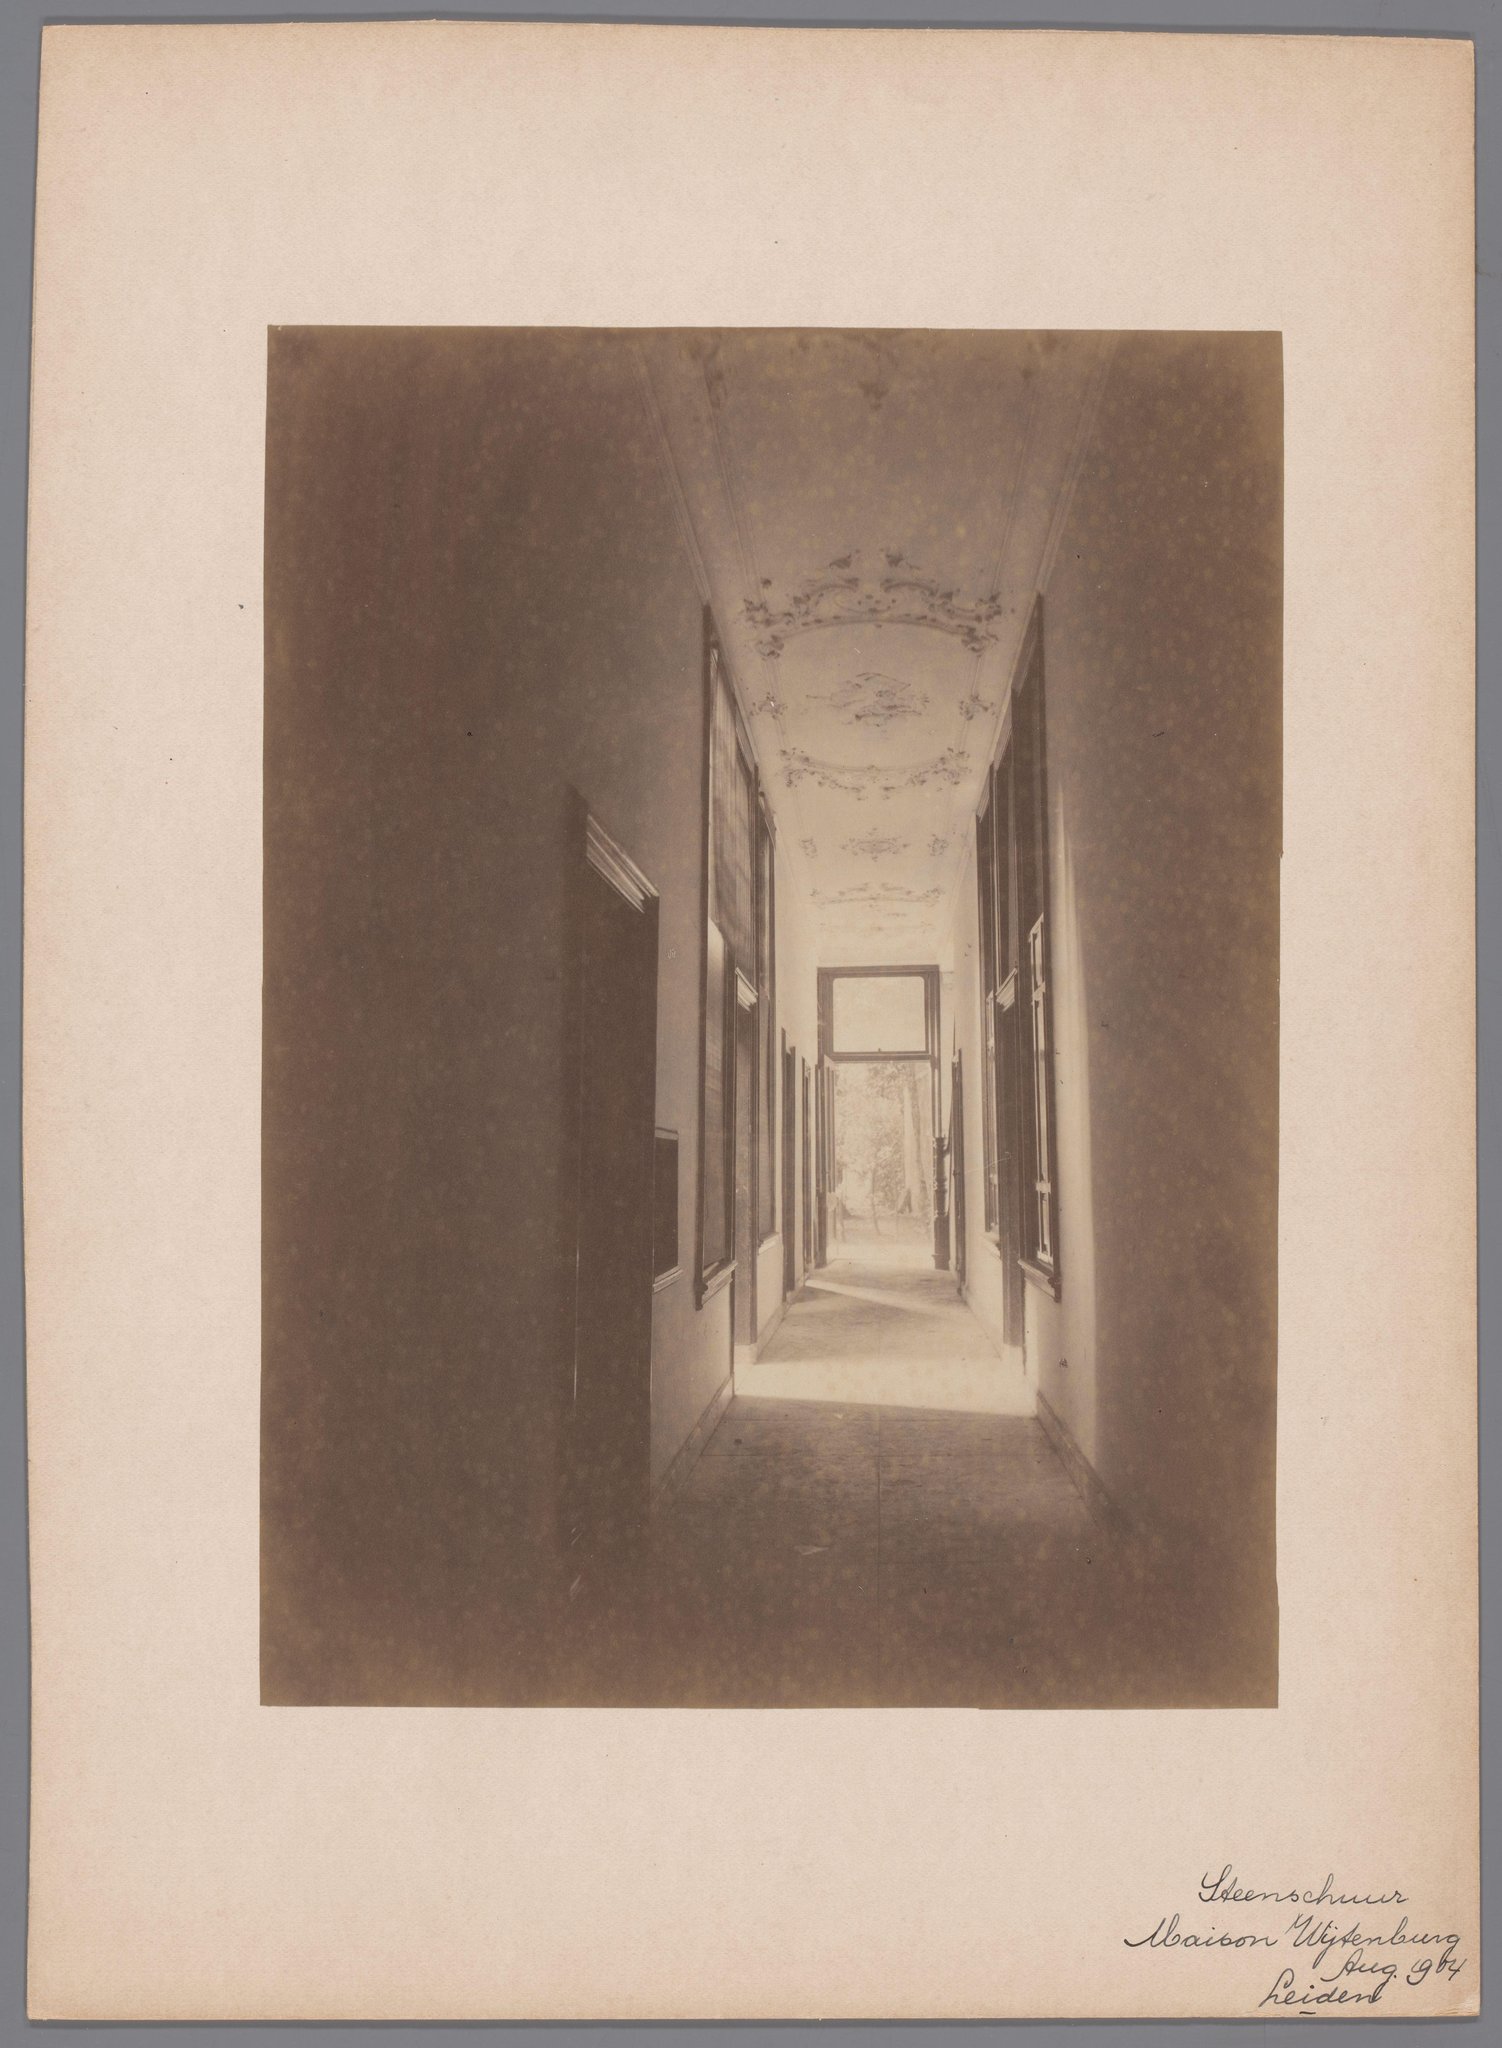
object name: photograph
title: Gang van Steenschuur 7 of Maison Wijtenburg te Leiden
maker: anoniem (monumentenzorg)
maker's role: fotograaf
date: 1904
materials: cardboard, photographic support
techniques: albumen print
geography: steenschuur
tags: corridor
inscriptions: annotation: ‘Leiden (Z.H.)/ steenschuur/ Maison Wijtenburg/ Aug 1904’, annotation: ‘Steenschuur/ Maison Wijtenburg/ Aug. 1904/ Leiden’, collector's mark: ‘R:MUS.’ Lugt 2228